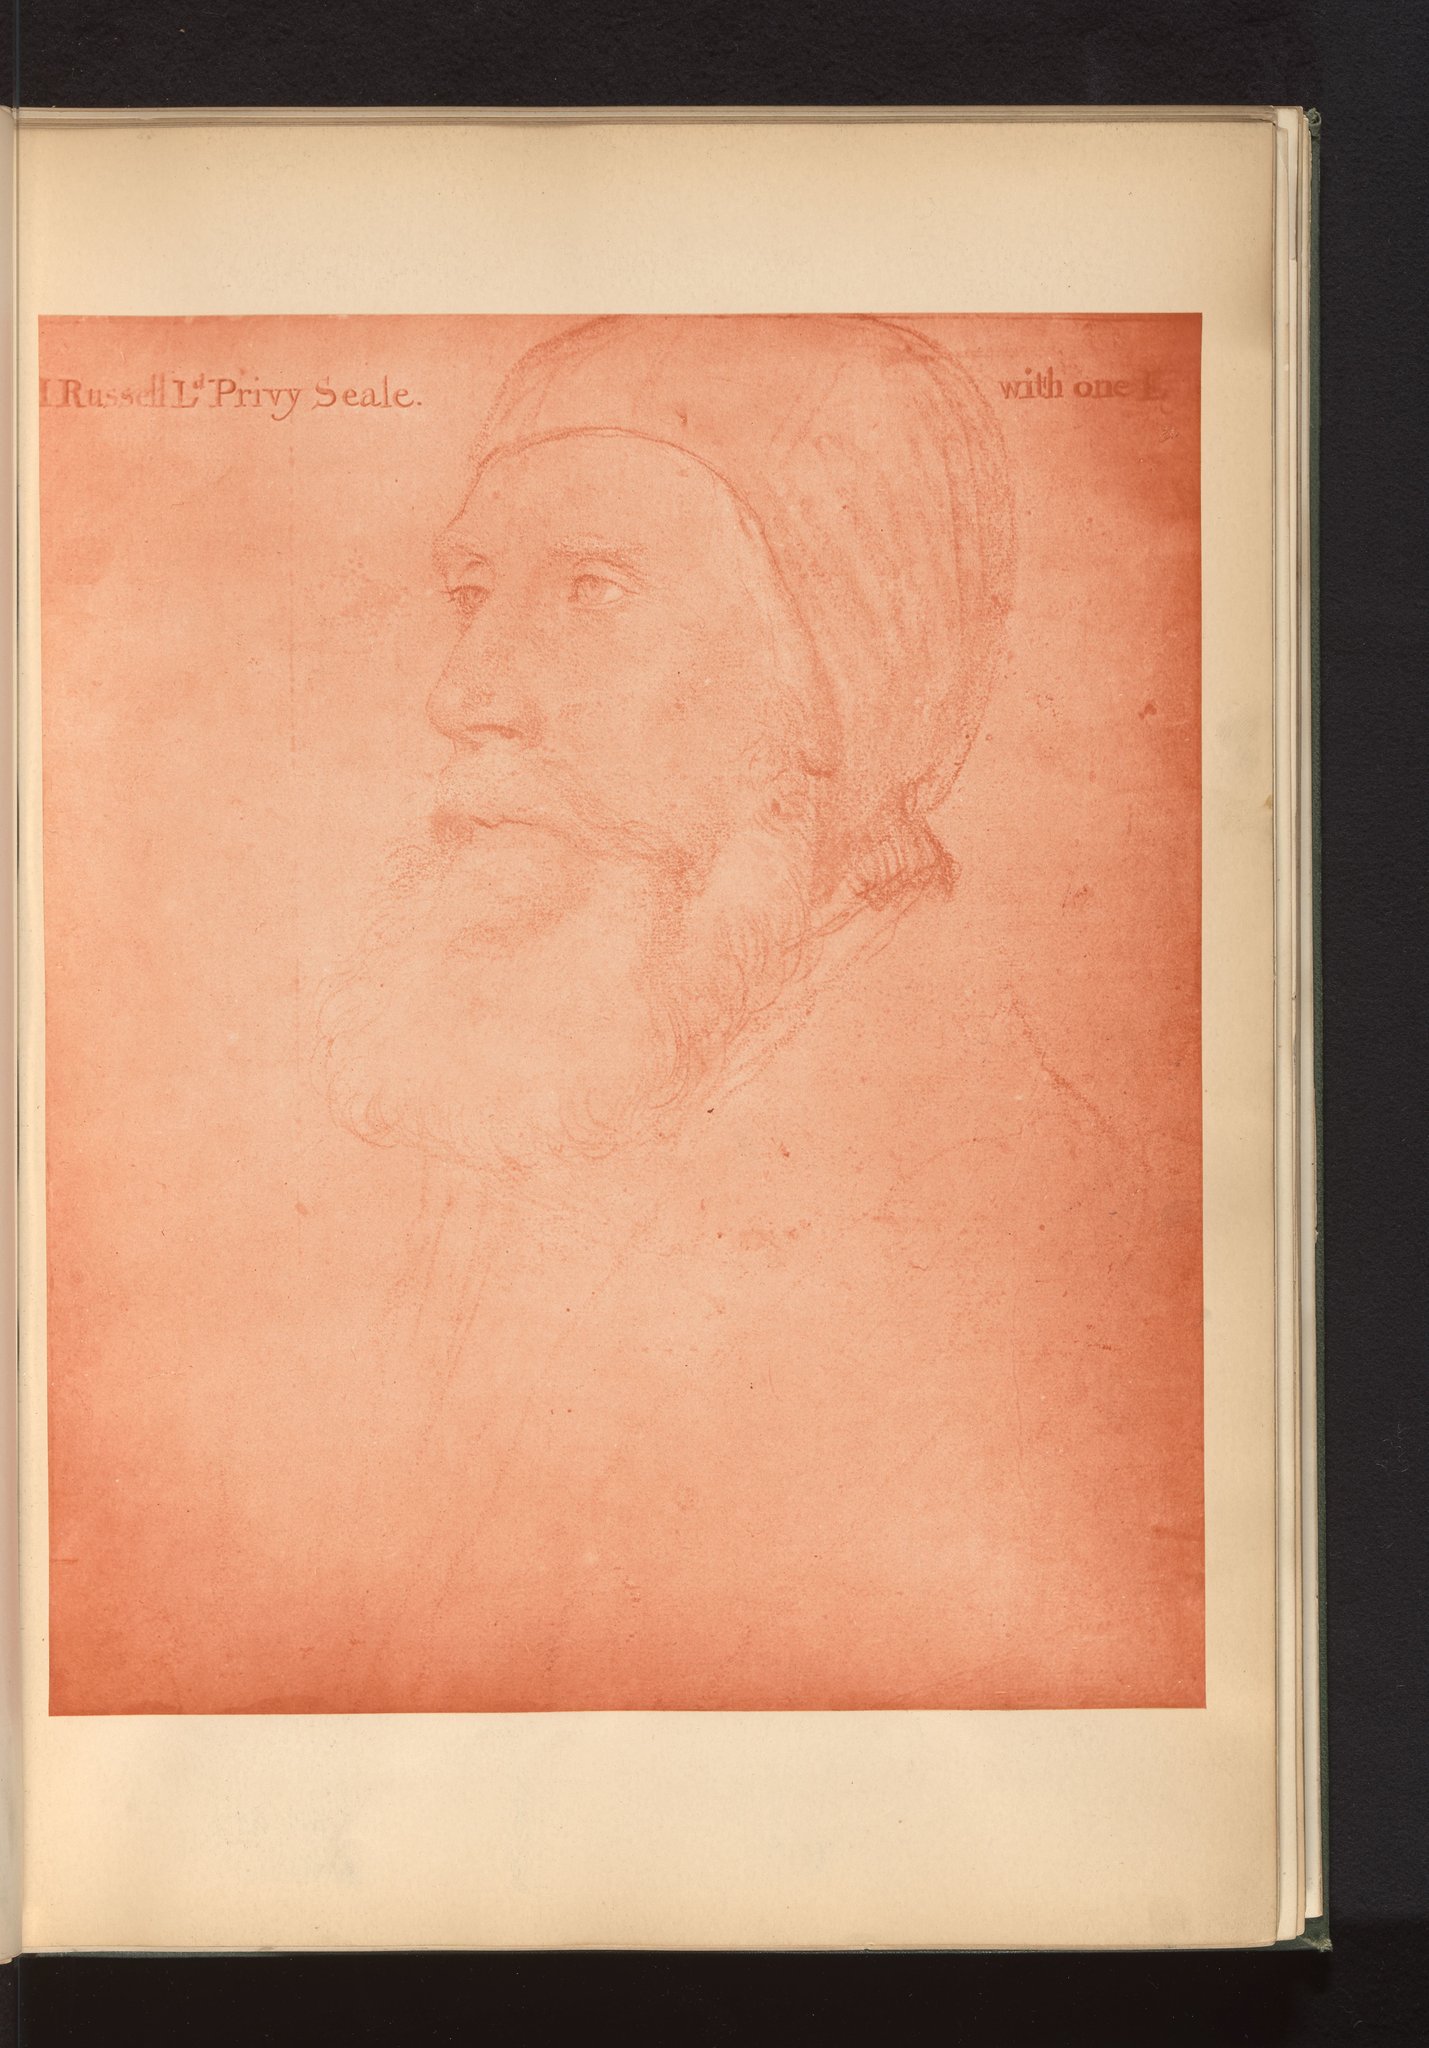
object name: photograph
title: Fotoreproductie van een portret van John Russell, graaf van Bedford, door Hans Holbein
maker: Anonymous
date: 1872-1877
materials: paper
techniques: carbon print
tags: drawing, sketch, historical persons, politician, e.g. party leader